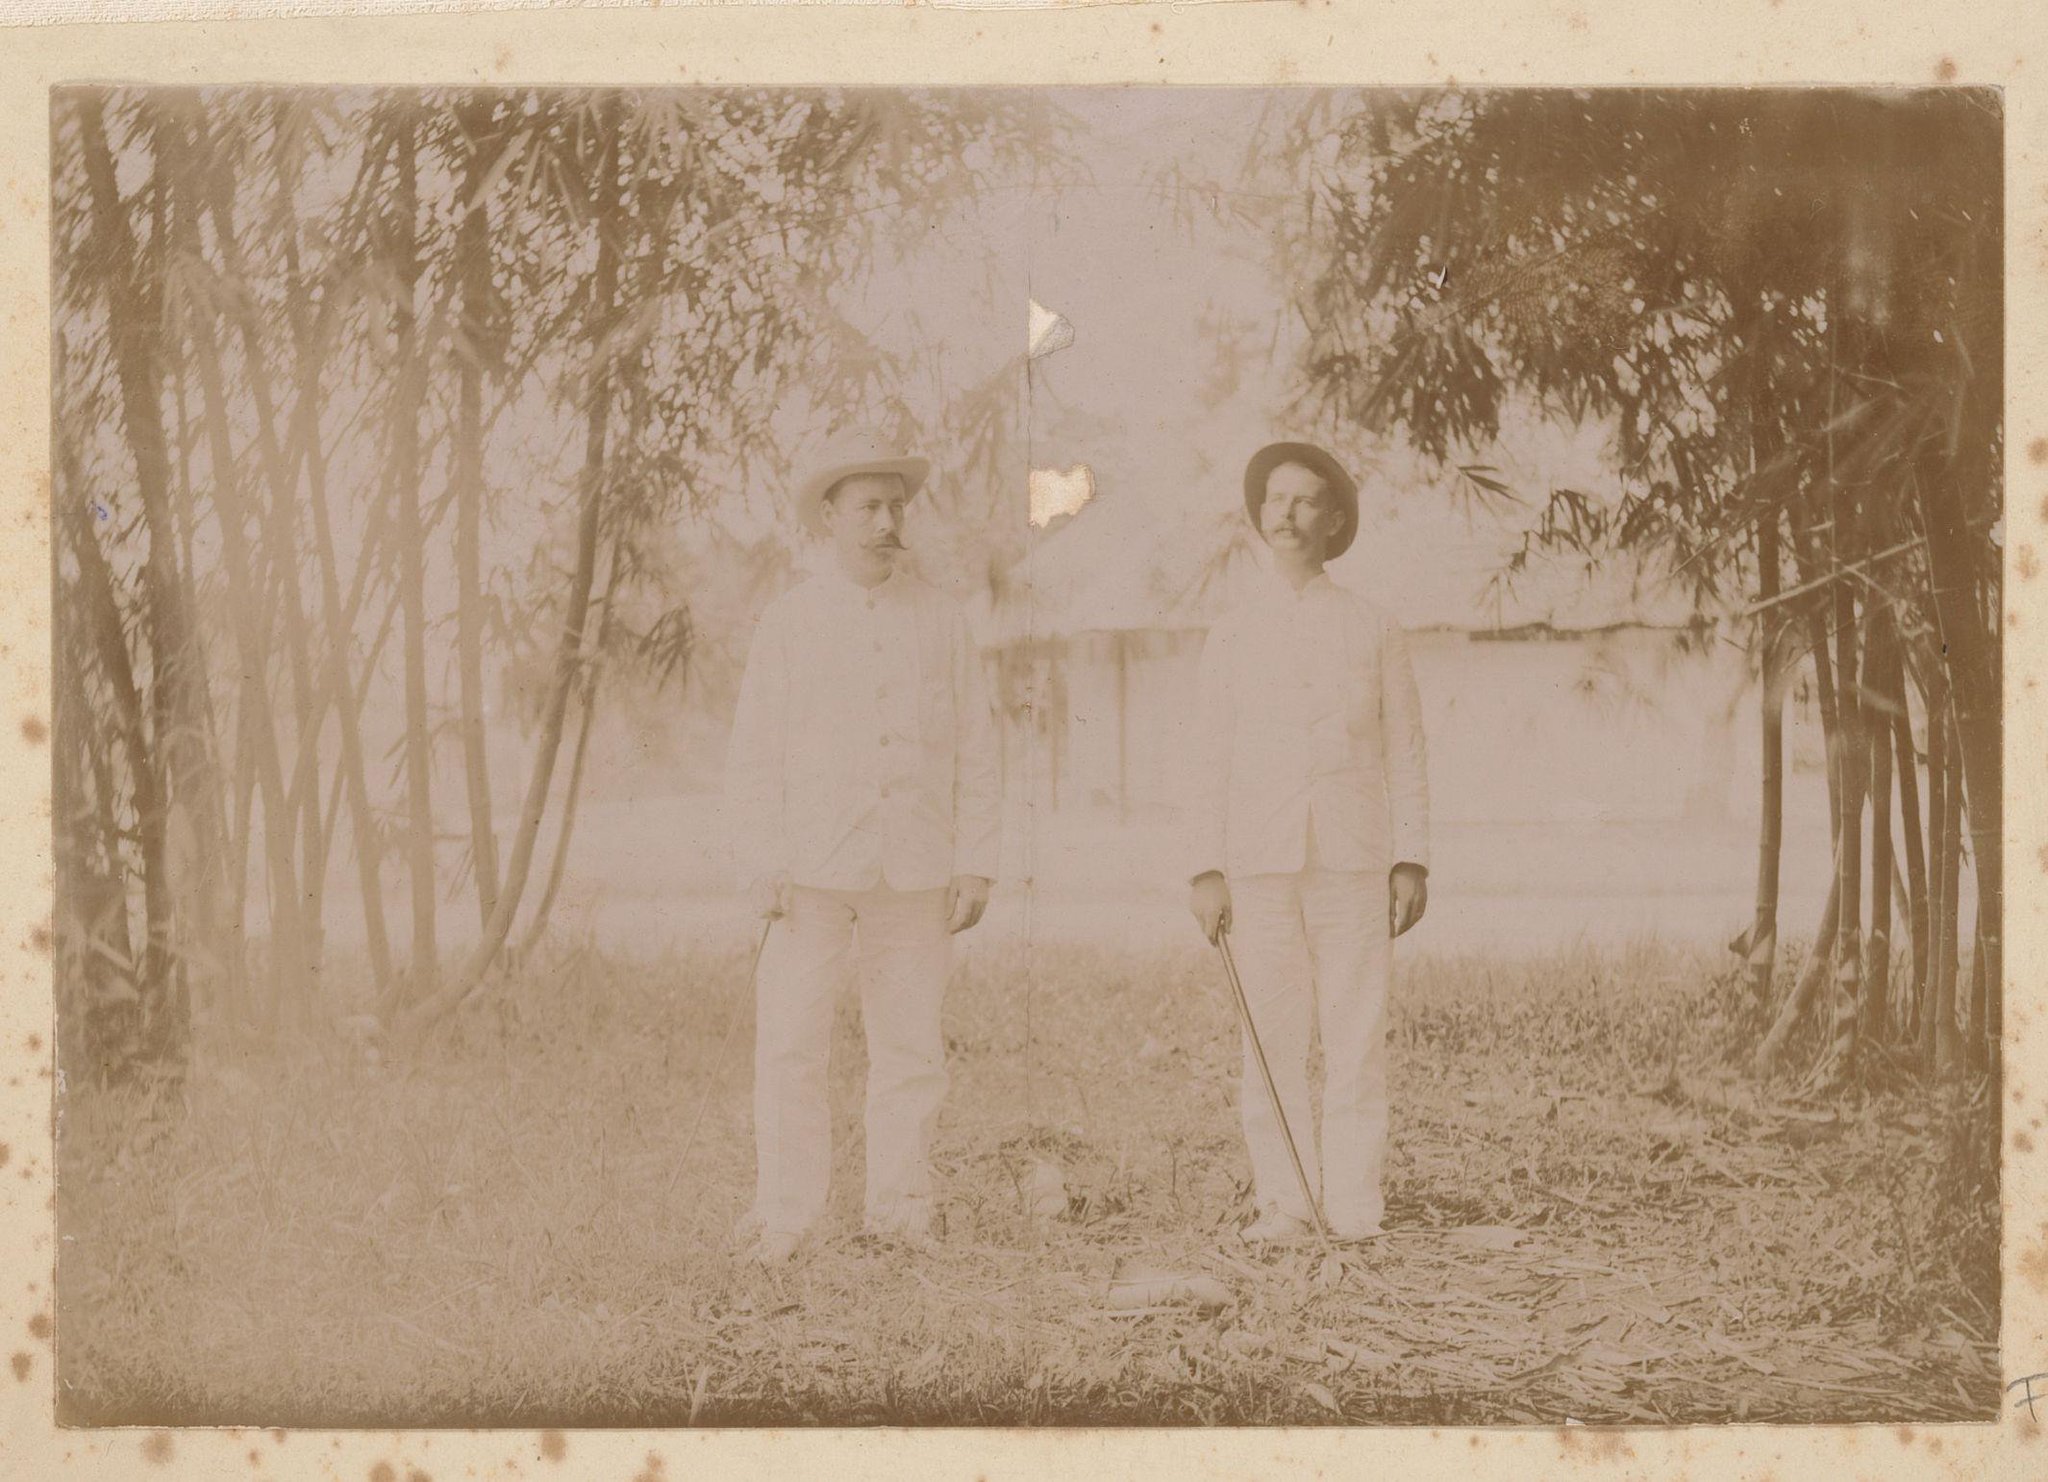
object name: album leaf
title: Nederlands-Indië, twee Hollanders staand in tuin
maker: Anonymous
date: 1890-1910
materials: photographic support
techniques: daylight paper print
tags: europeans, trees, historical persons, dutch east indies, the